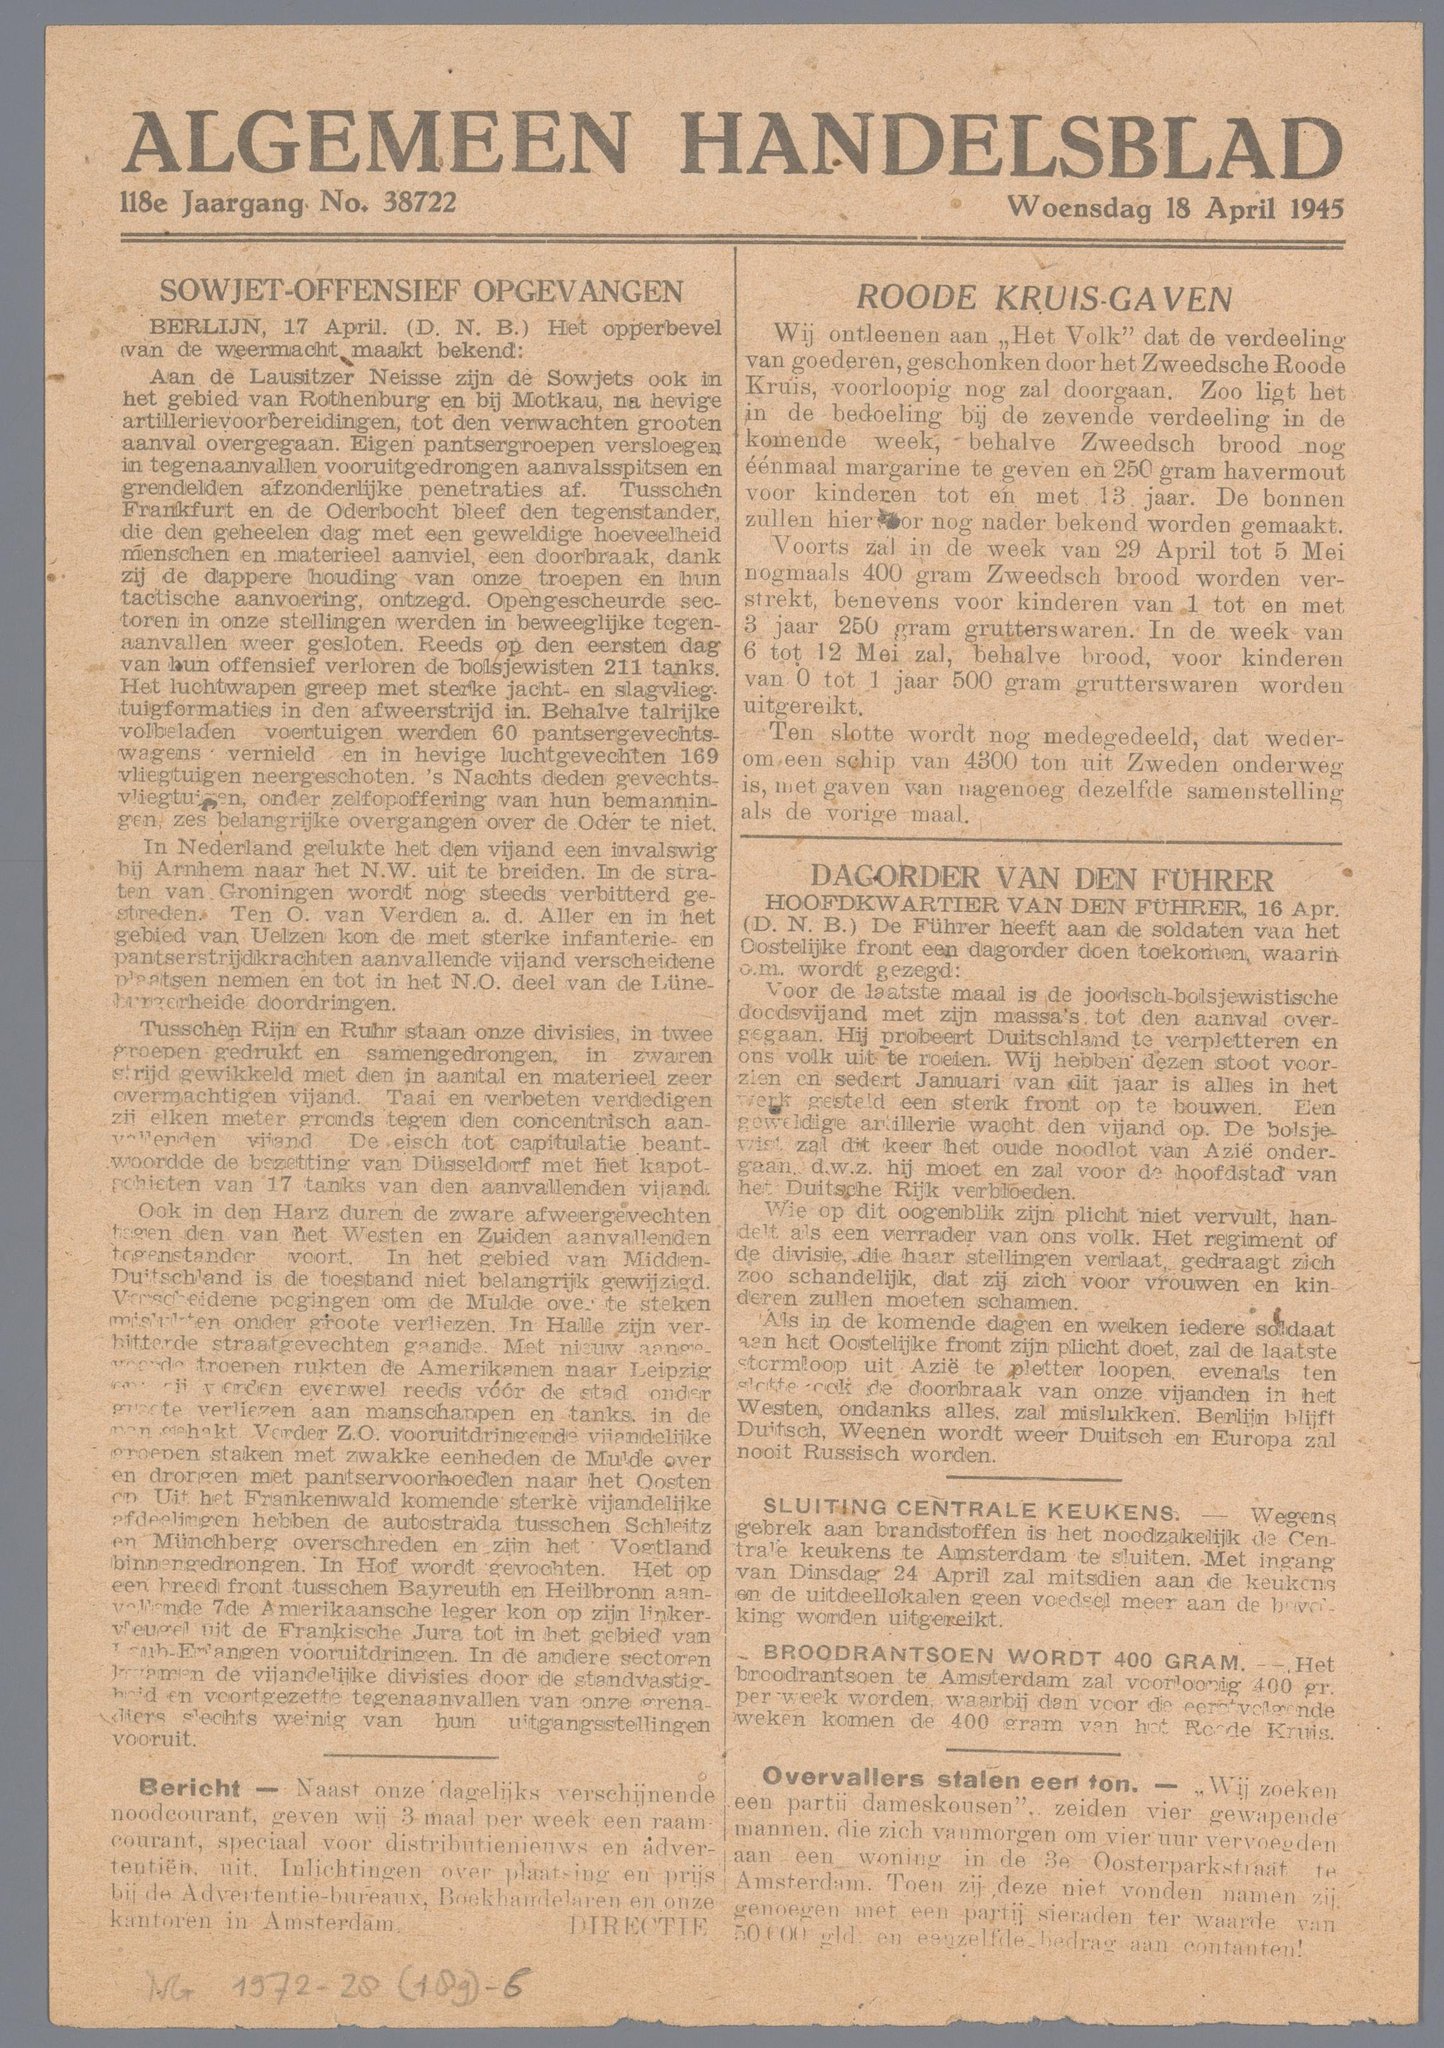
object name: newspaper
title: Algemeen Handelsblad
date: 1945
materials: paper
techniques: printing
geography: amsterdam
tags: tweede wereldoorlog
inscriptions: date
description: Krant, klein formaat, met bericht over de oorlog uit Duits gezinde hoek. Gedateerd: Woensdag, 18-04-1945.